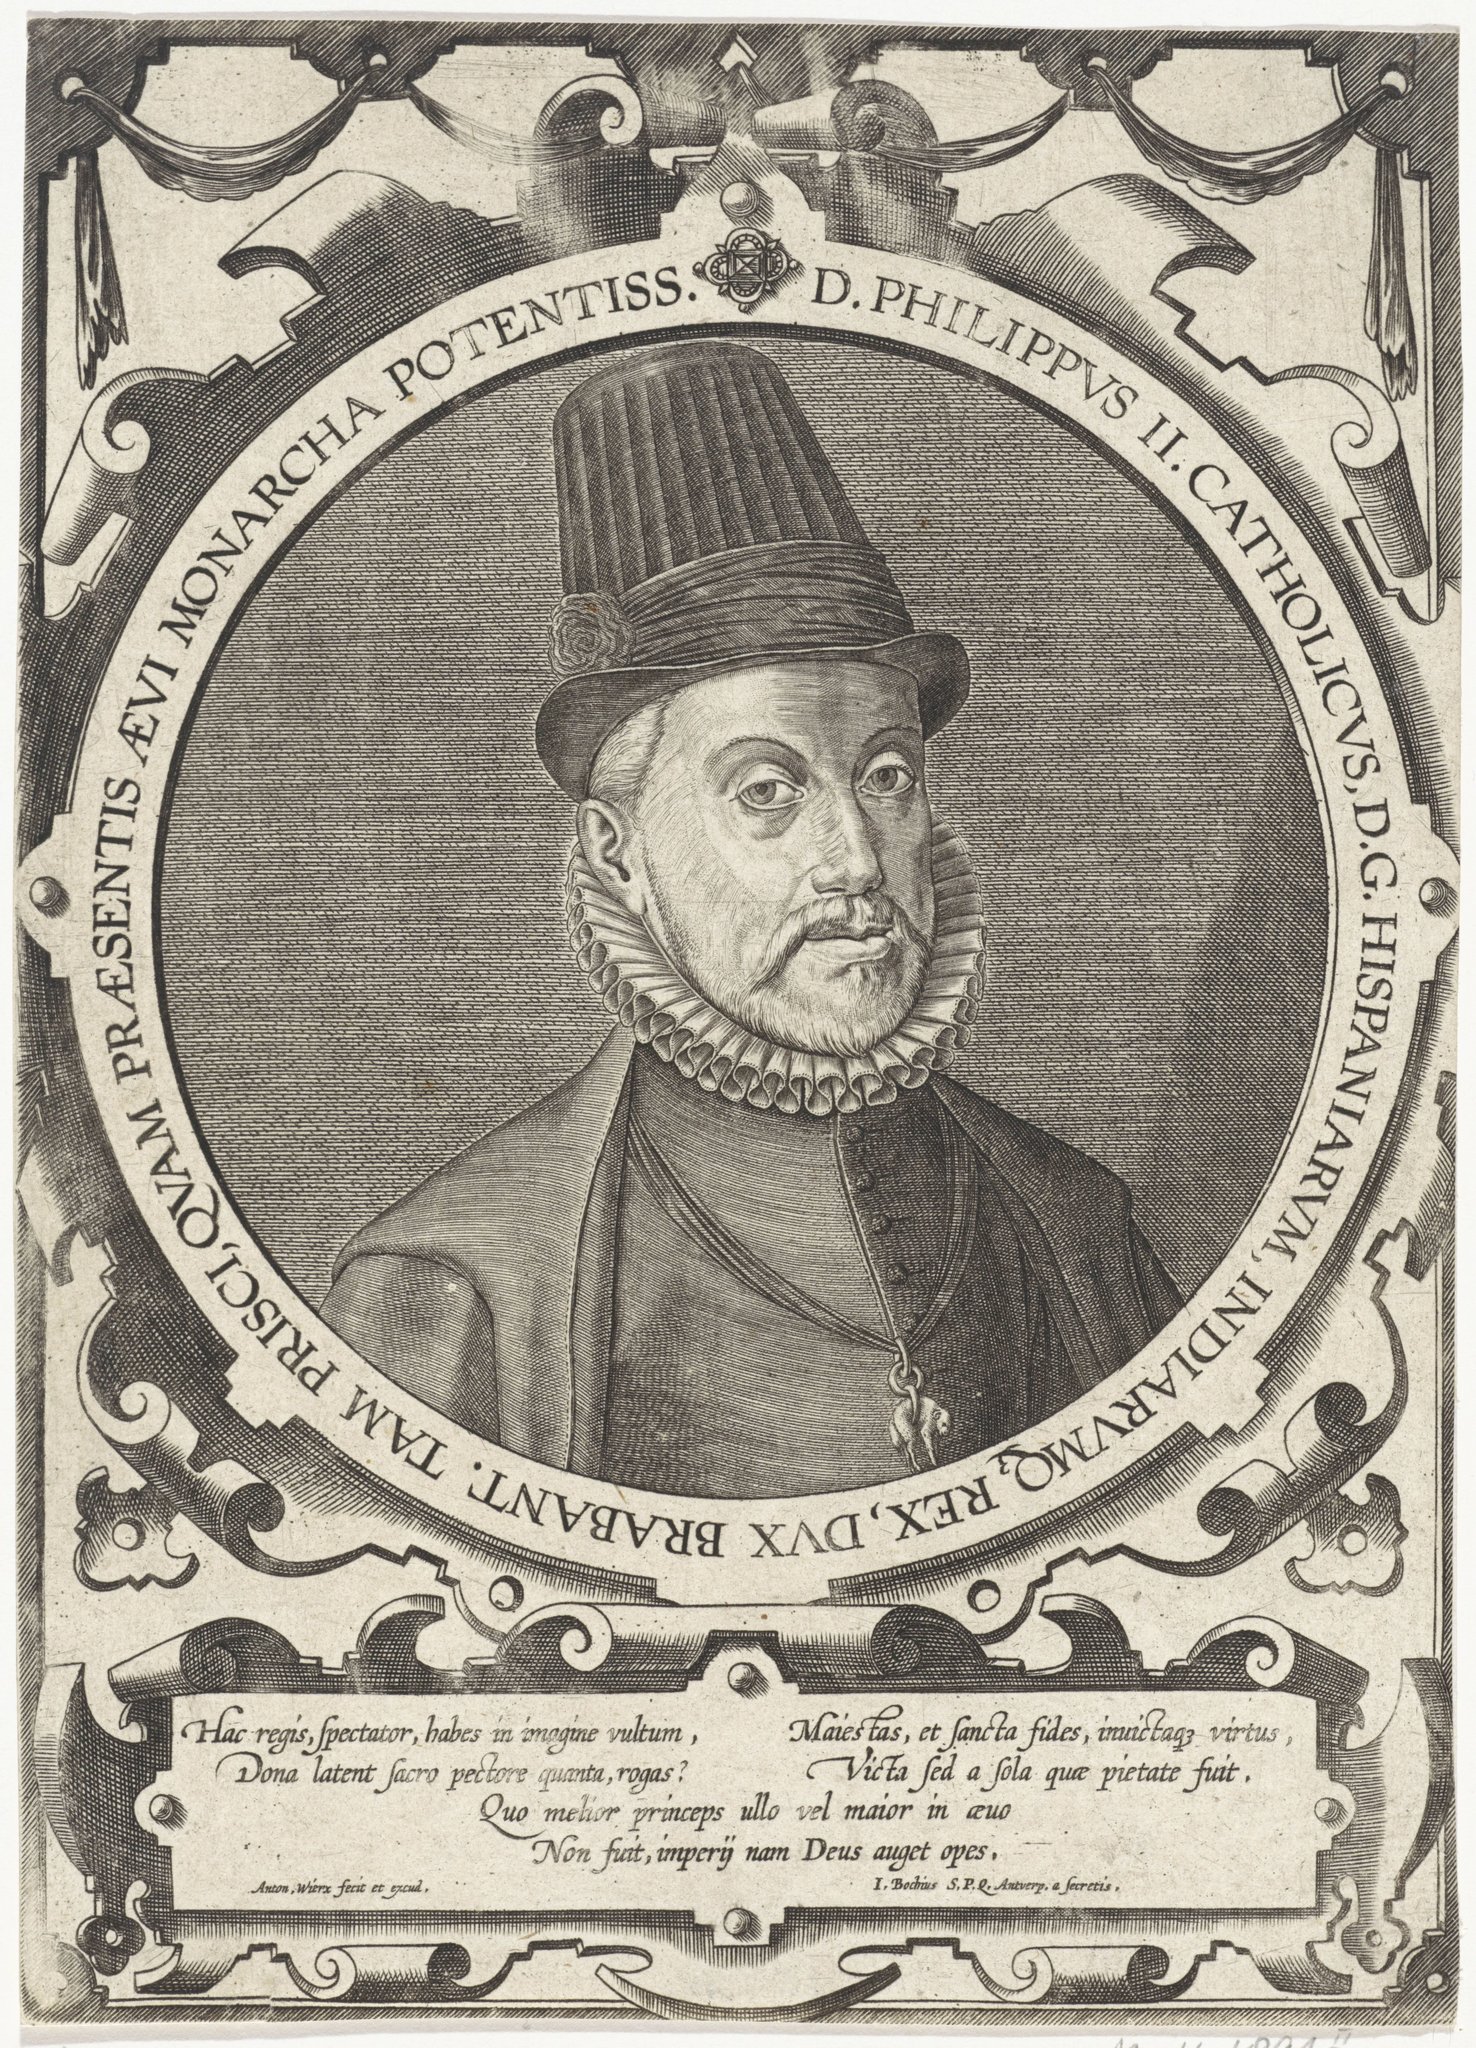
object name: print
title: Portretten van regeerders van de Nederlanden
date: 1599-1604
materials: paper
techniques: engraving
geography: antwerp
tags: philip ii of spain, knighthood order of the golden fleece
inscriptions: number: ‘22. - 40.’, collector's mark: Lugt 2228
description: Portret van Filips II, koning van Spanje. Hij draagt een lint met de Orde van het Gulden Vlies. In de cartouche onder zijn portret een zesregelig gedicht, in drie kolommen, in het Latijn.